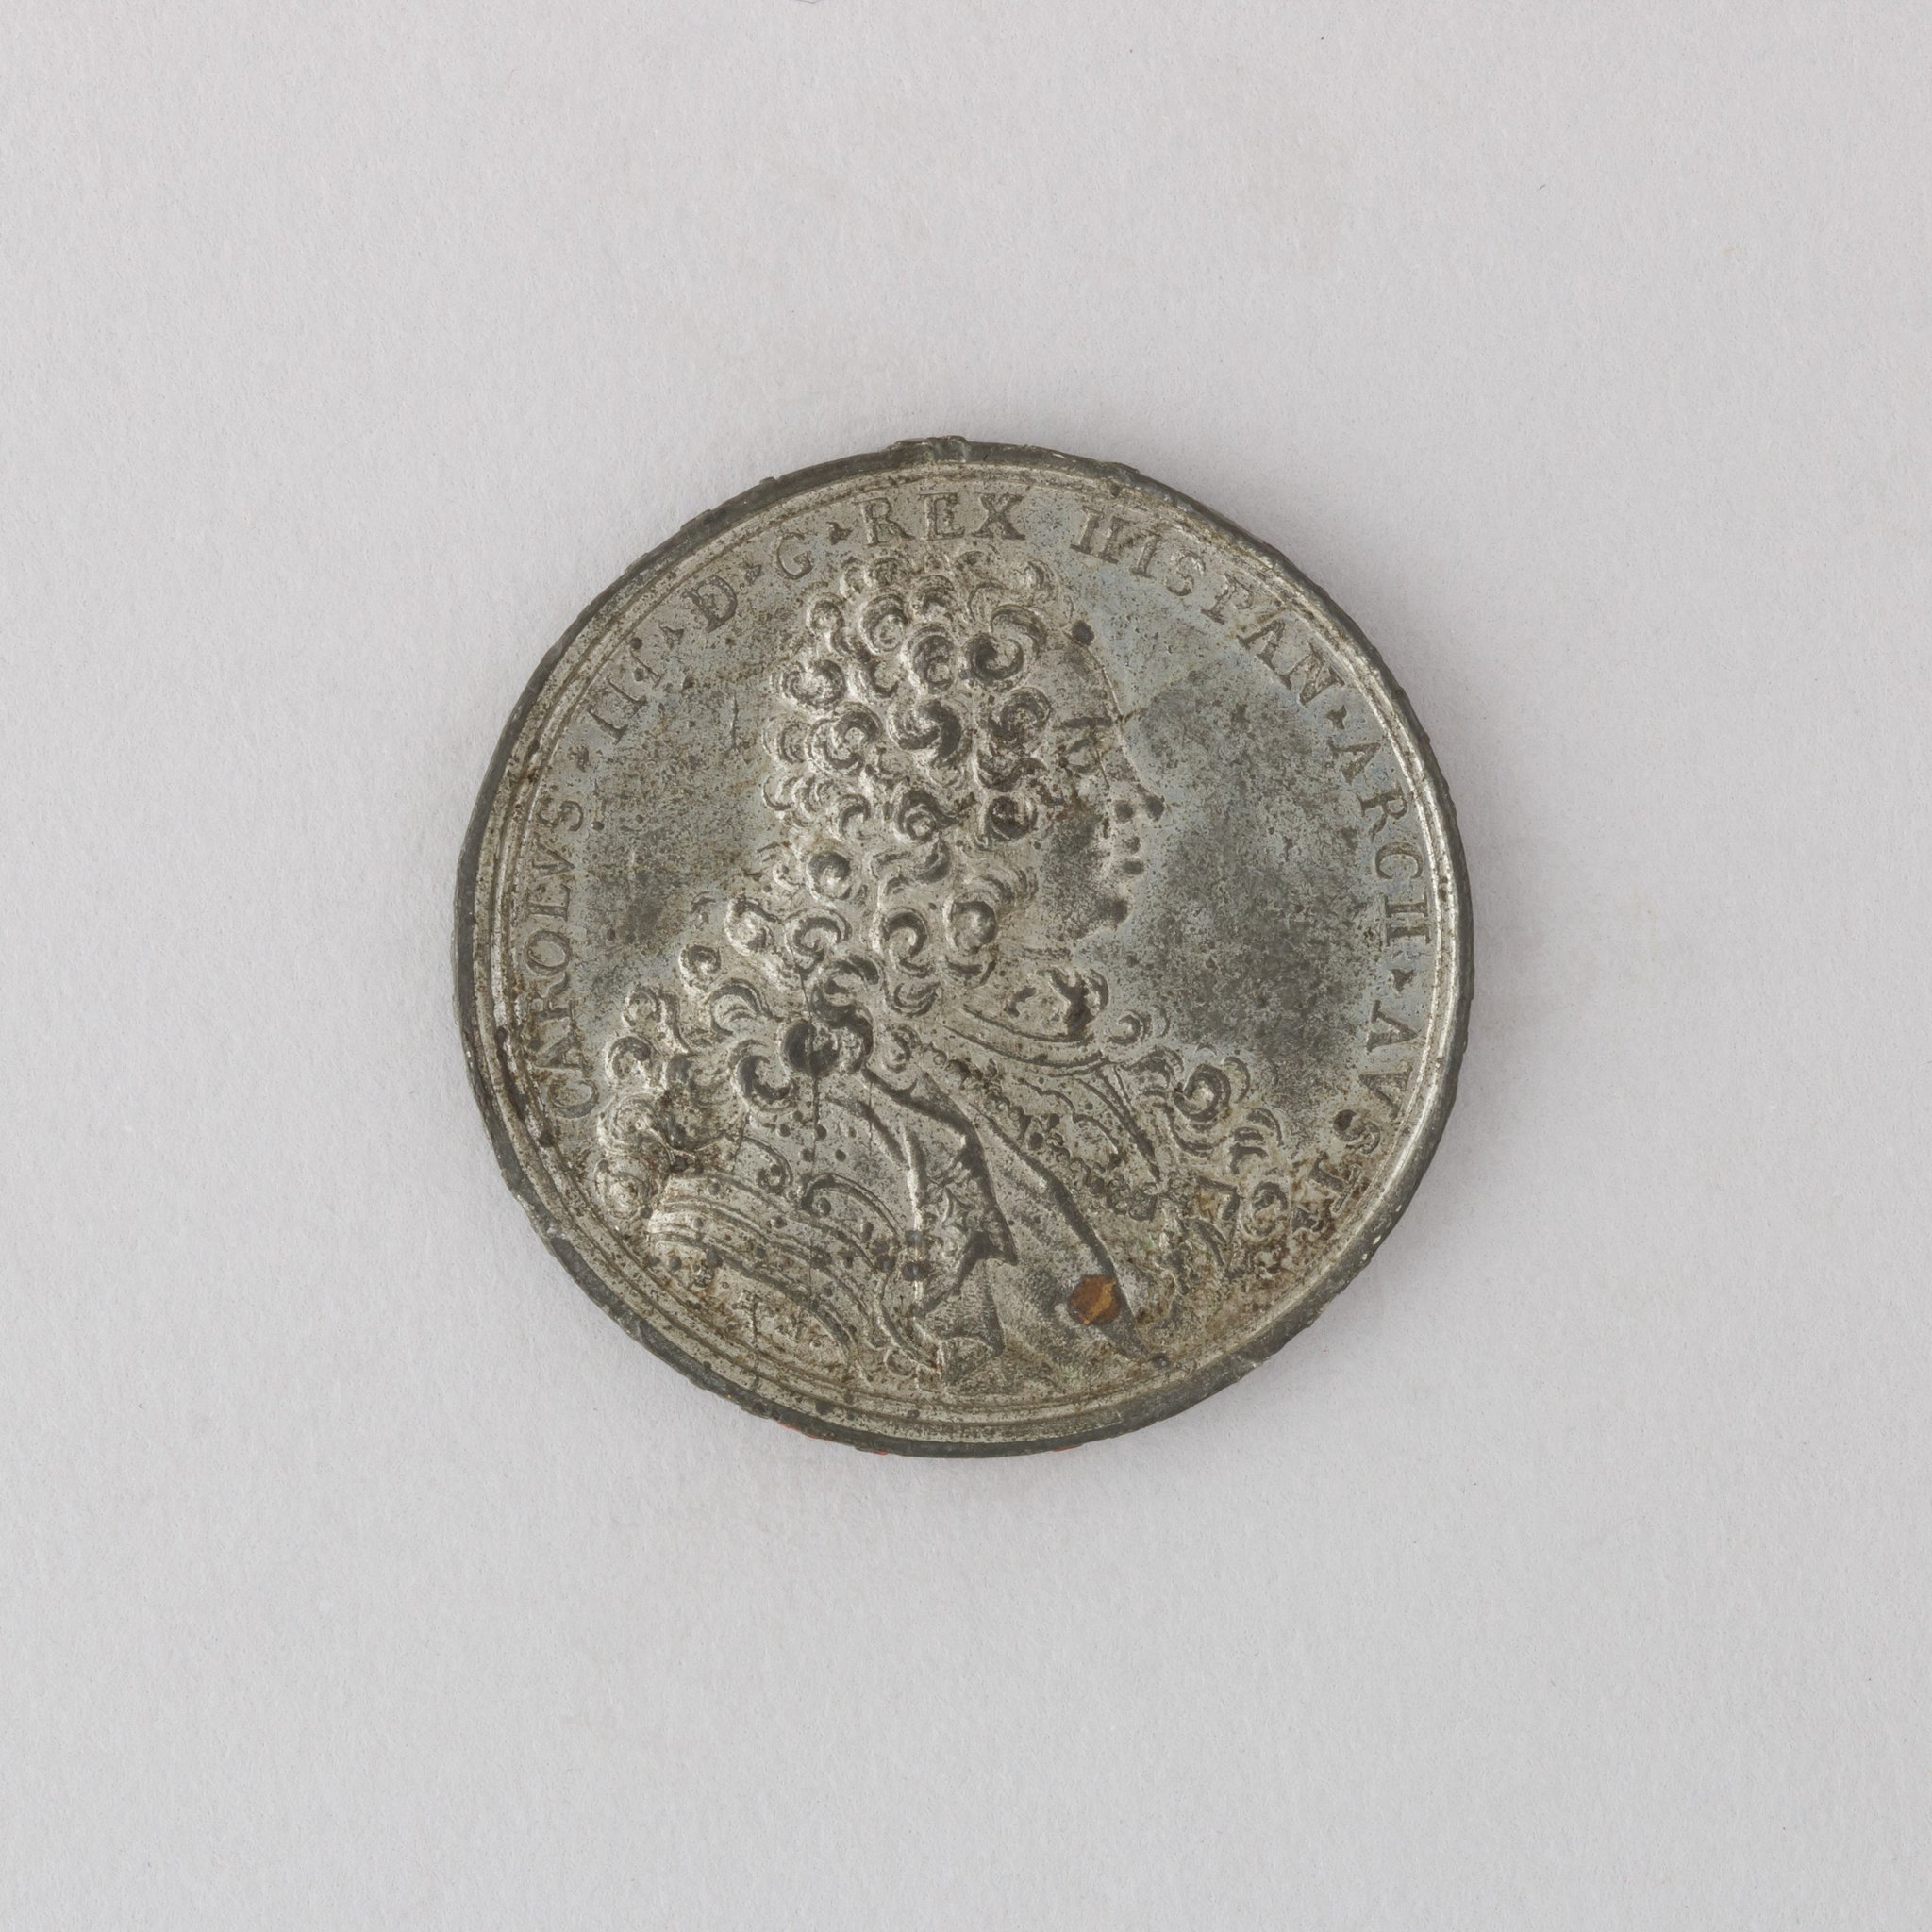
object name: medal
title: Medal Commorating Barcelona Relieved, 1706, Showing Charles, Archduke of Austria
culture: austrian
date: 1701-1733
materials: pewter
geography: austria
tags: men